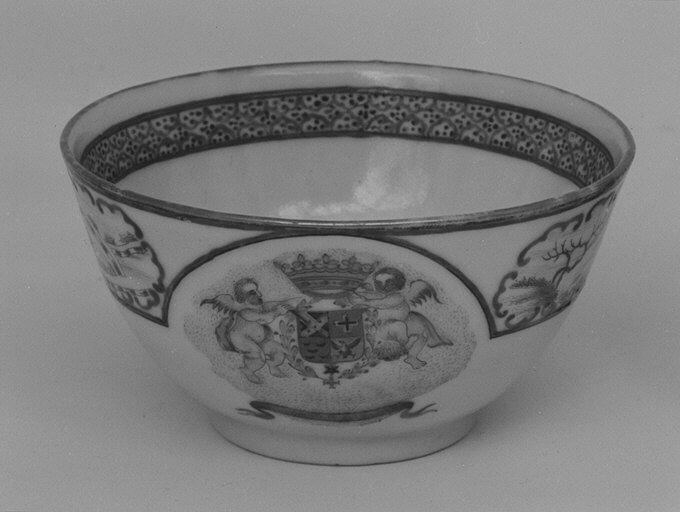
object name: teacup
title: Tea cup (part of a service)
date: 1800-1805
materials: hard paste porcelain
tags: coat of arms